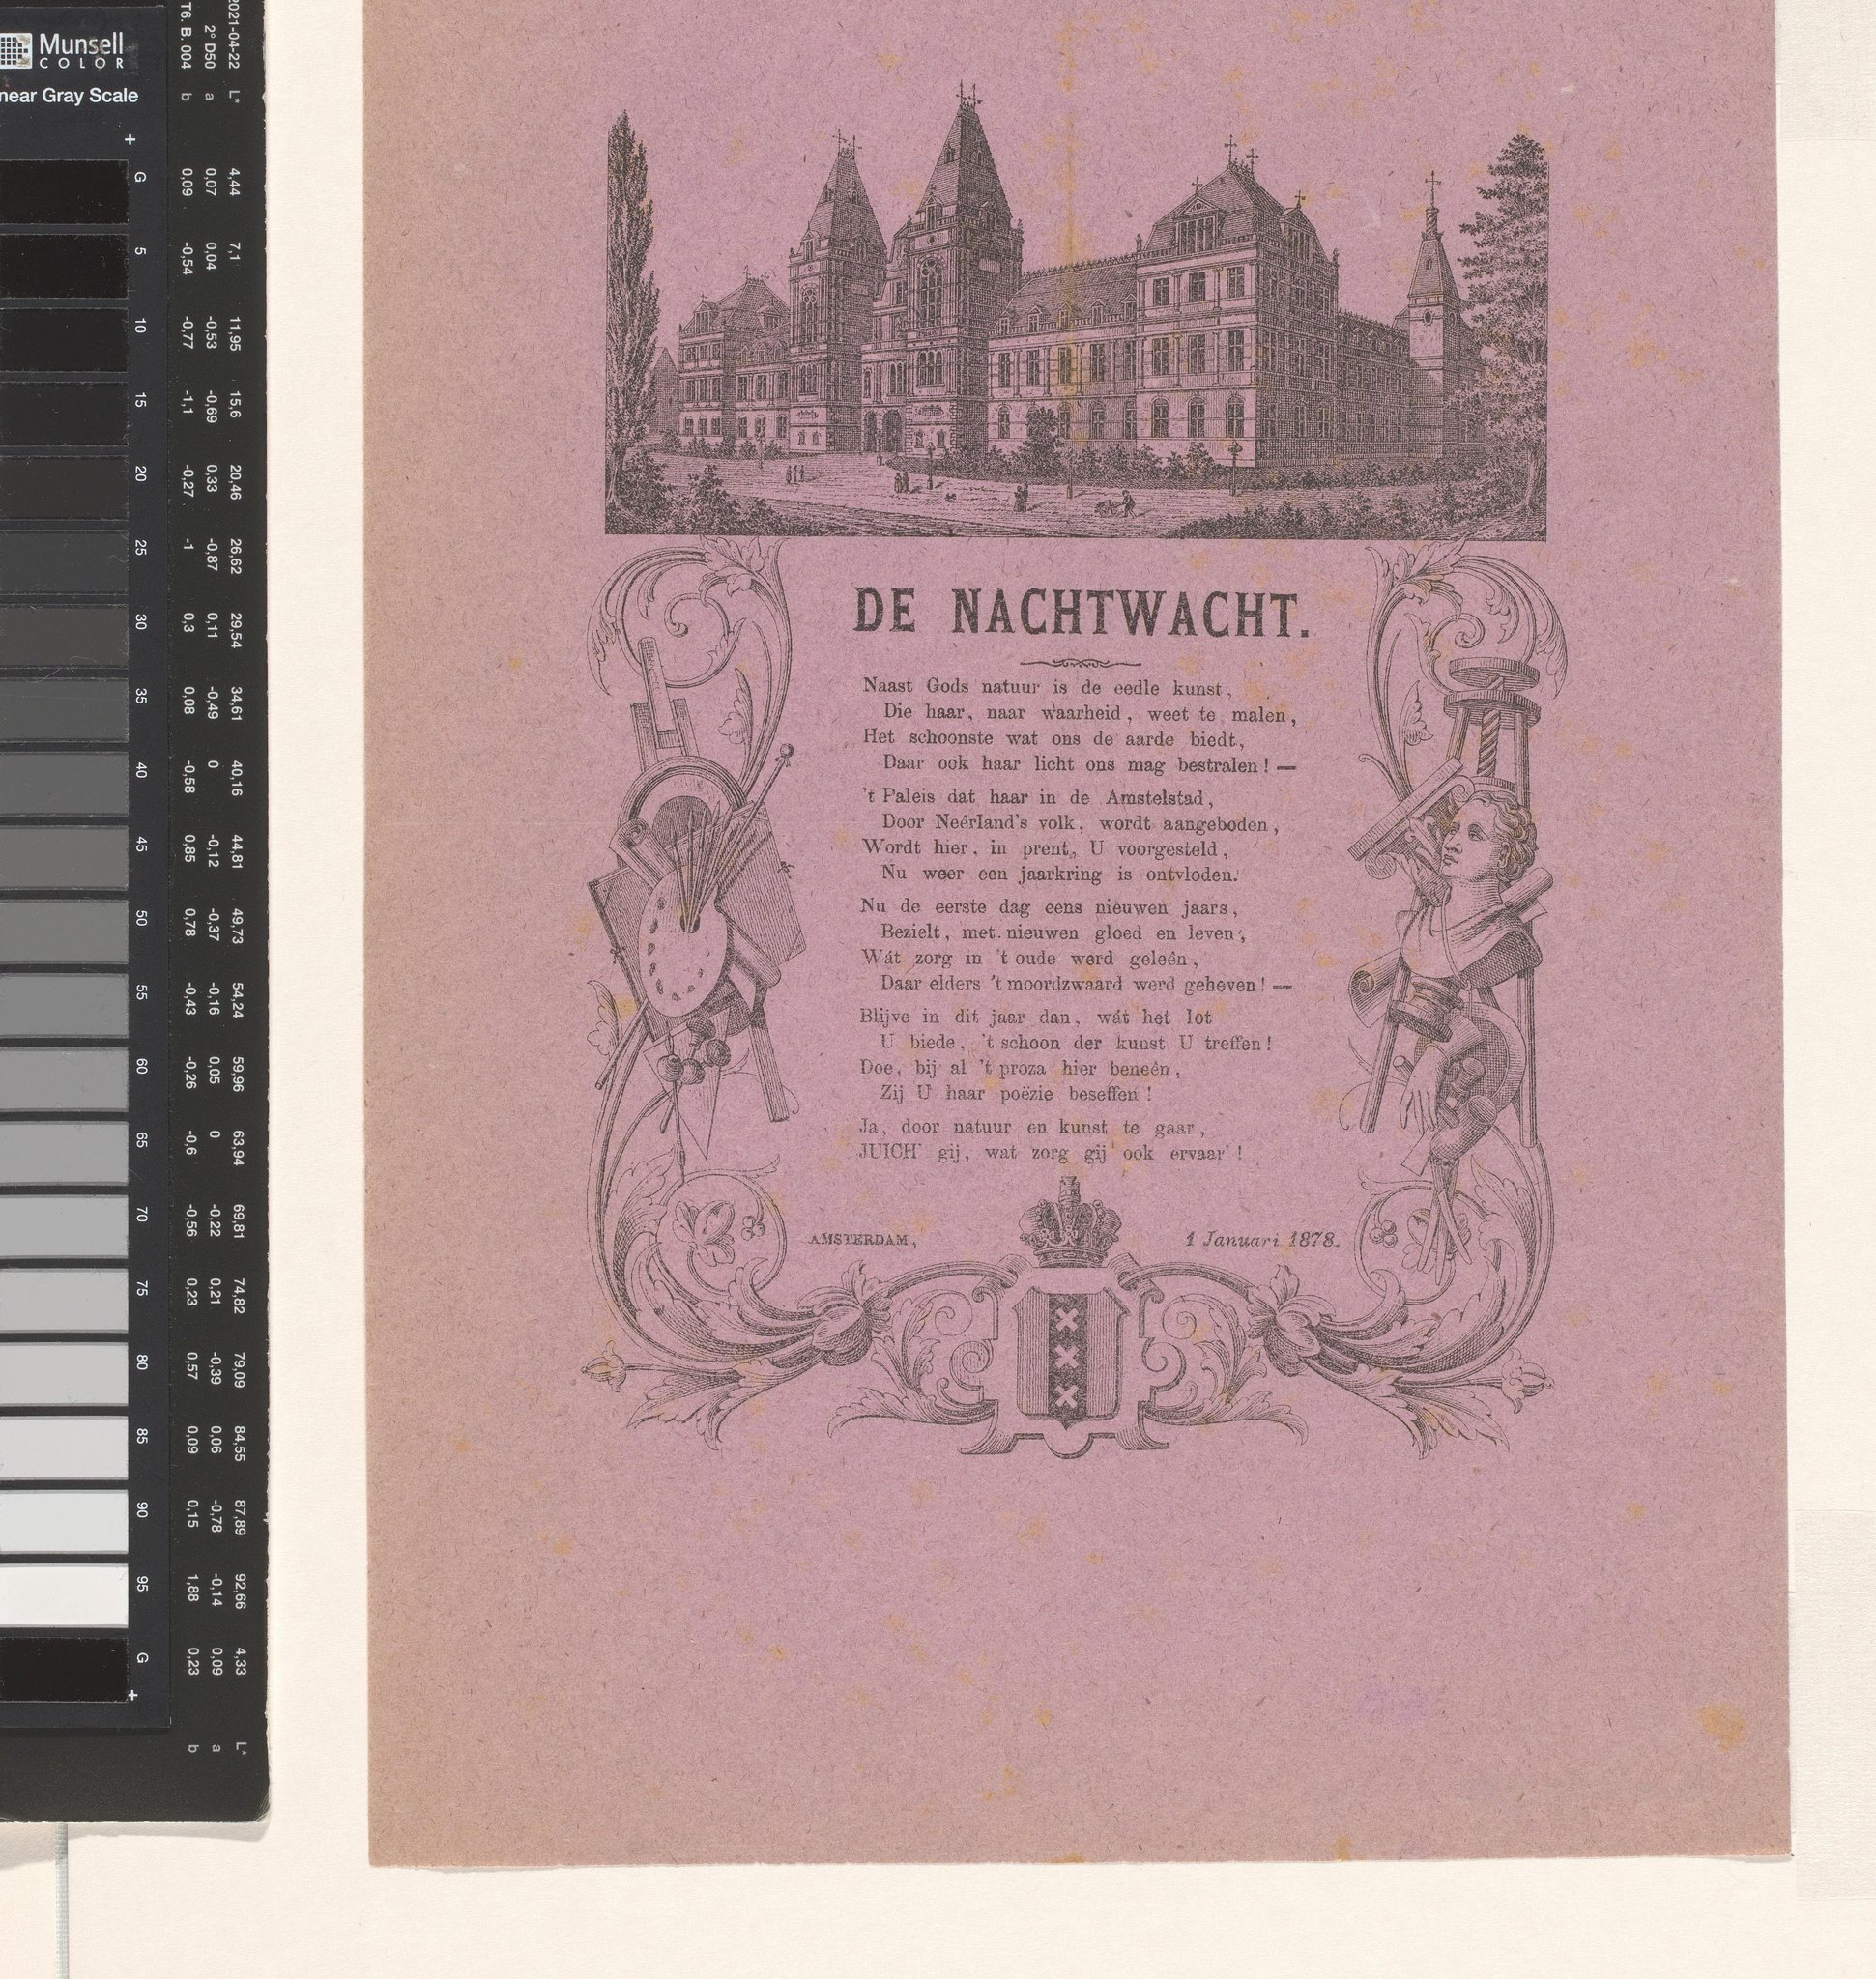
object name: print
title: Nieuwjaarswens van de Amsterdamse nachtwacht voor het jaar 1878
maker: Anonymous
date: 1877-1878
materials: paper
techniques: lithograph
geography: amsterdam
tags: night patrol, device (as symbol of the state, etc.) (+ city; municipal)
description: Nieuwjaarswens van de Amsterdamse nachtwacht (ratelwacht) voor het jaar 1878. Centraal een gedicht, met daarboven als afbeelding een presentatietekening van het te bouwen Rijksmuseum naar ontwerp van Cuypers. Om het gedicht een gedecoreerde lijst met het wapen van Amsterdam en referenties aan de beeldende kunsten.